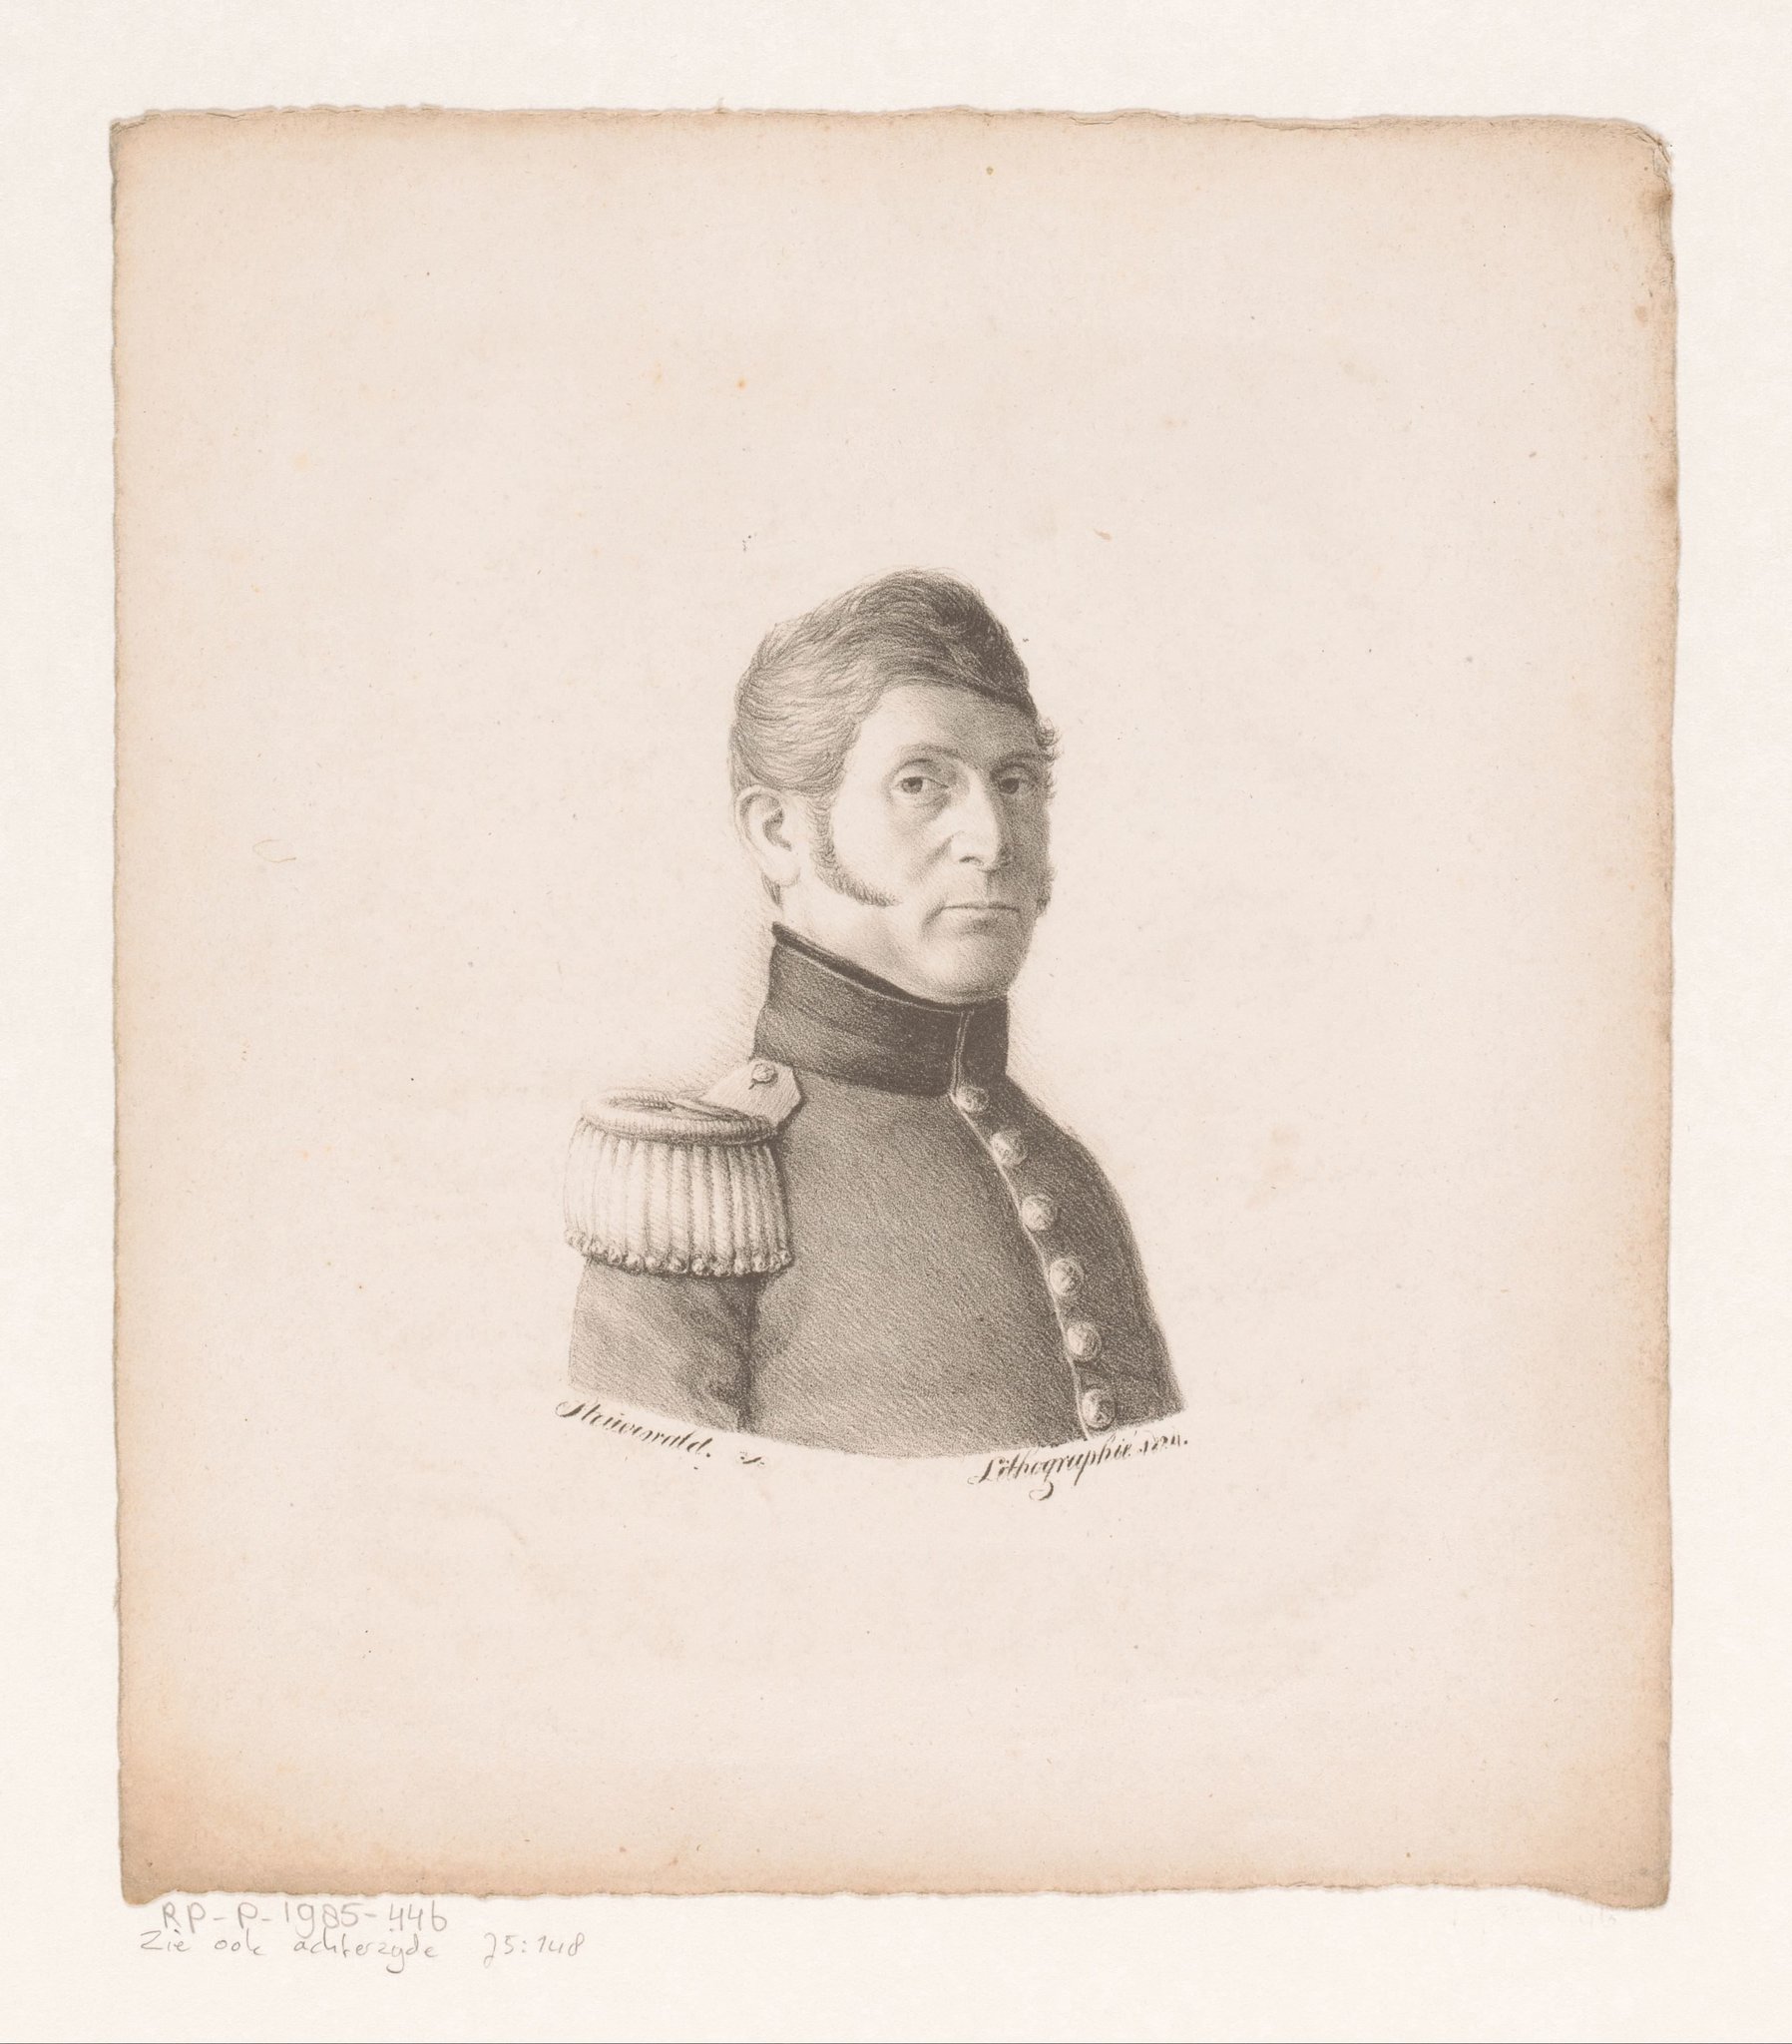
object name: print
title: Portret van onbekende militair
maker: christian heinrich gottlieb steuerwald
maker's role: draughtsman, print maker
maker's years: 1802-1874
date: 1822-1874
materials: paper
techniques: lithograph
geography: dordrecht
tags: anonymous historical person portrayed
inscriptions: collector's mark: Lugt 2228, collector's mark: Lugt 2760